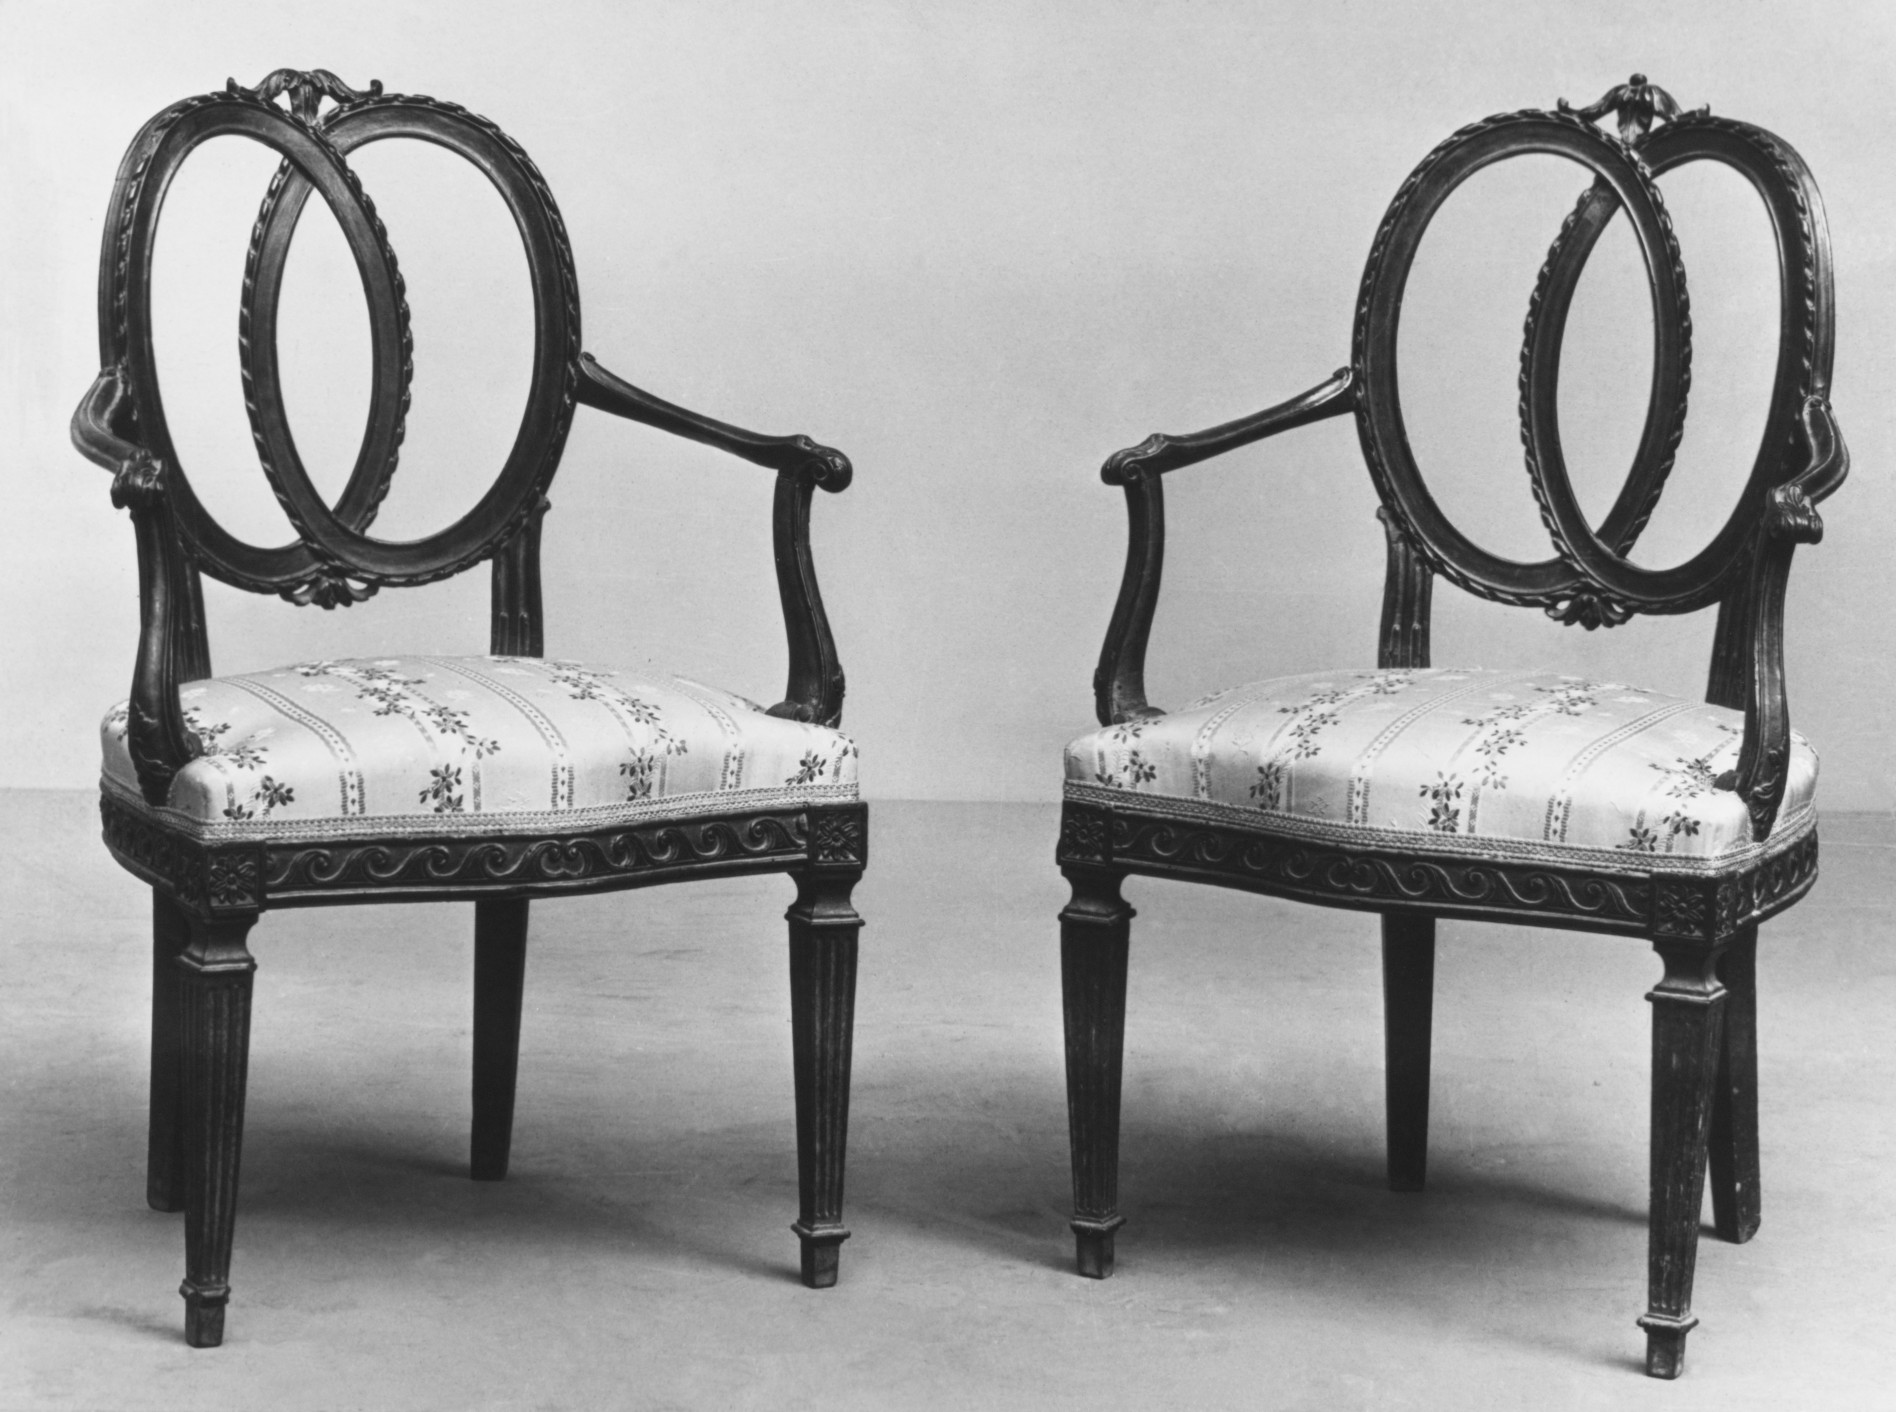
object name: armchair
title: Pair of armchairs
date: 1767-1800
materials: wood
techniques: brocade